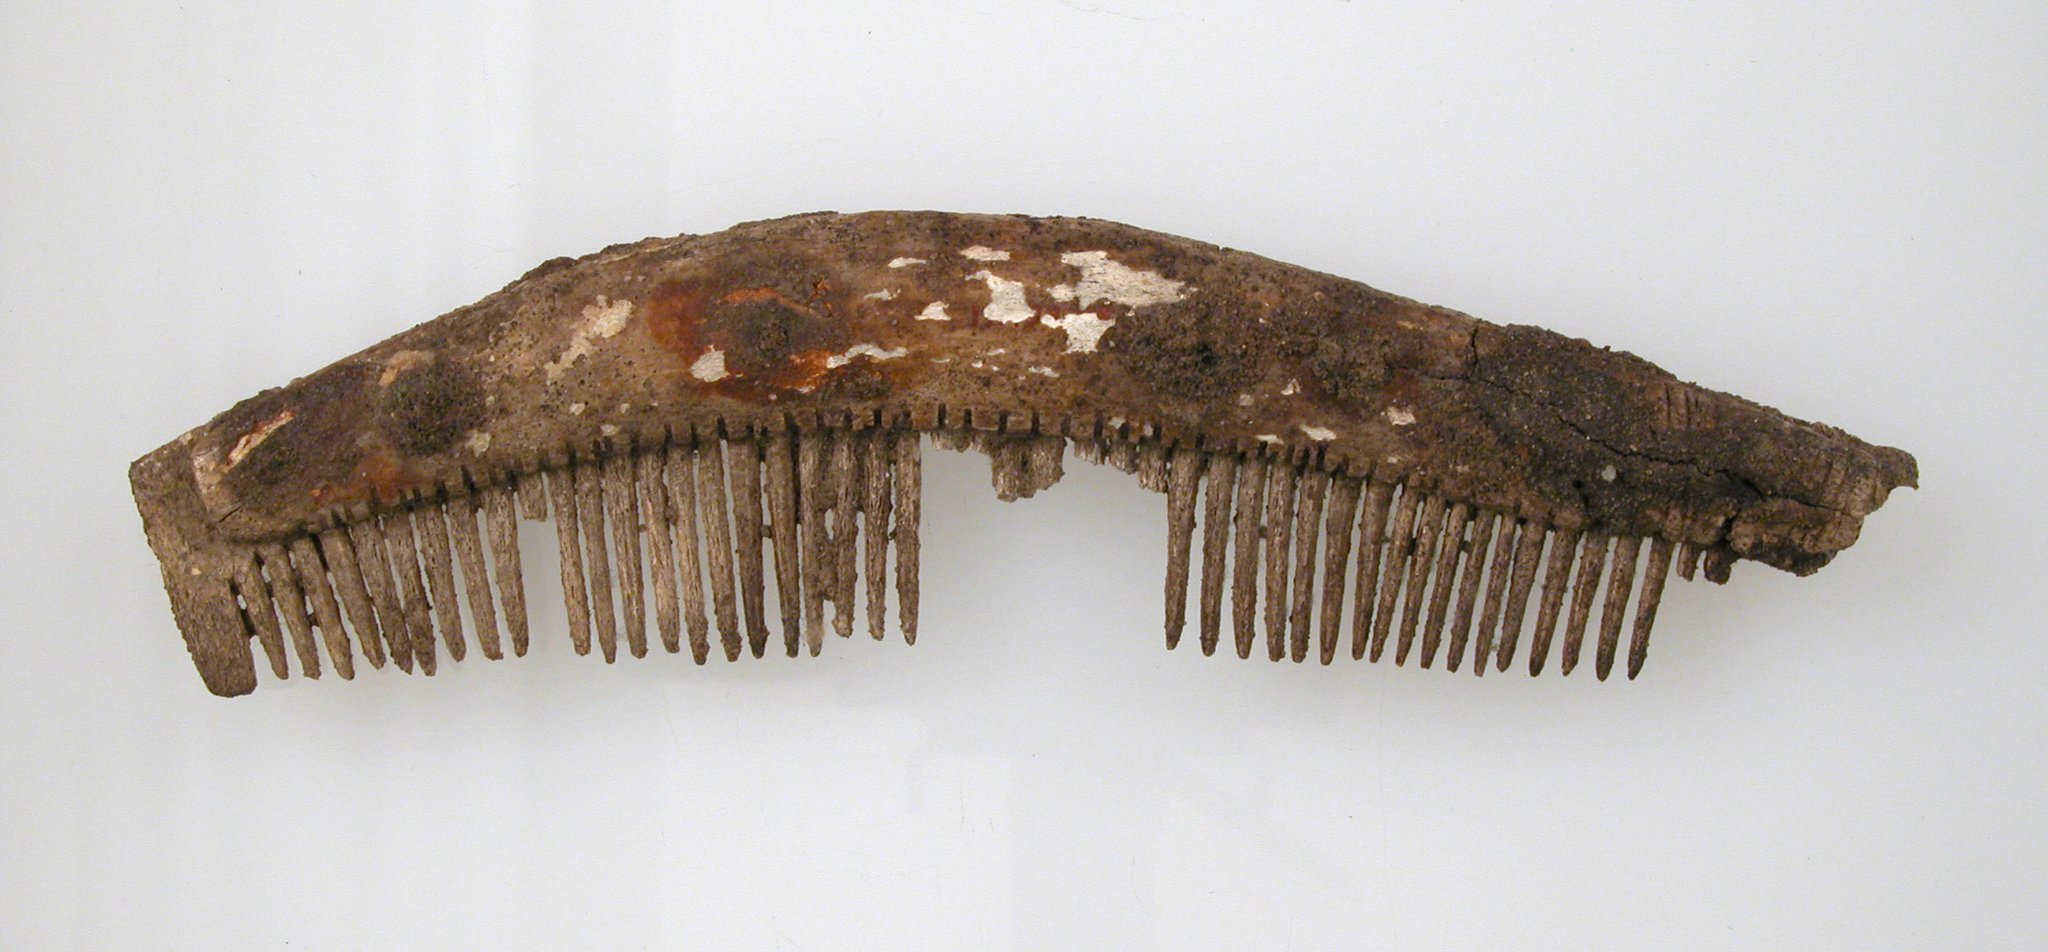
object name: comb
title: One Edged Comb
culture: frankish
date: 601-700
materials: bone, iron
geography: germany